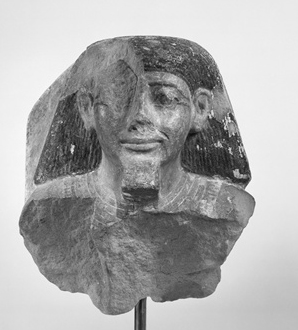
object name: statue, pair, man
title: Head and Shoulders of a Man from a Pair Statue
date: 1504-1425 BCE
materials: paint, stone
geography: egypt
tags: heads,men,hieroglyphs